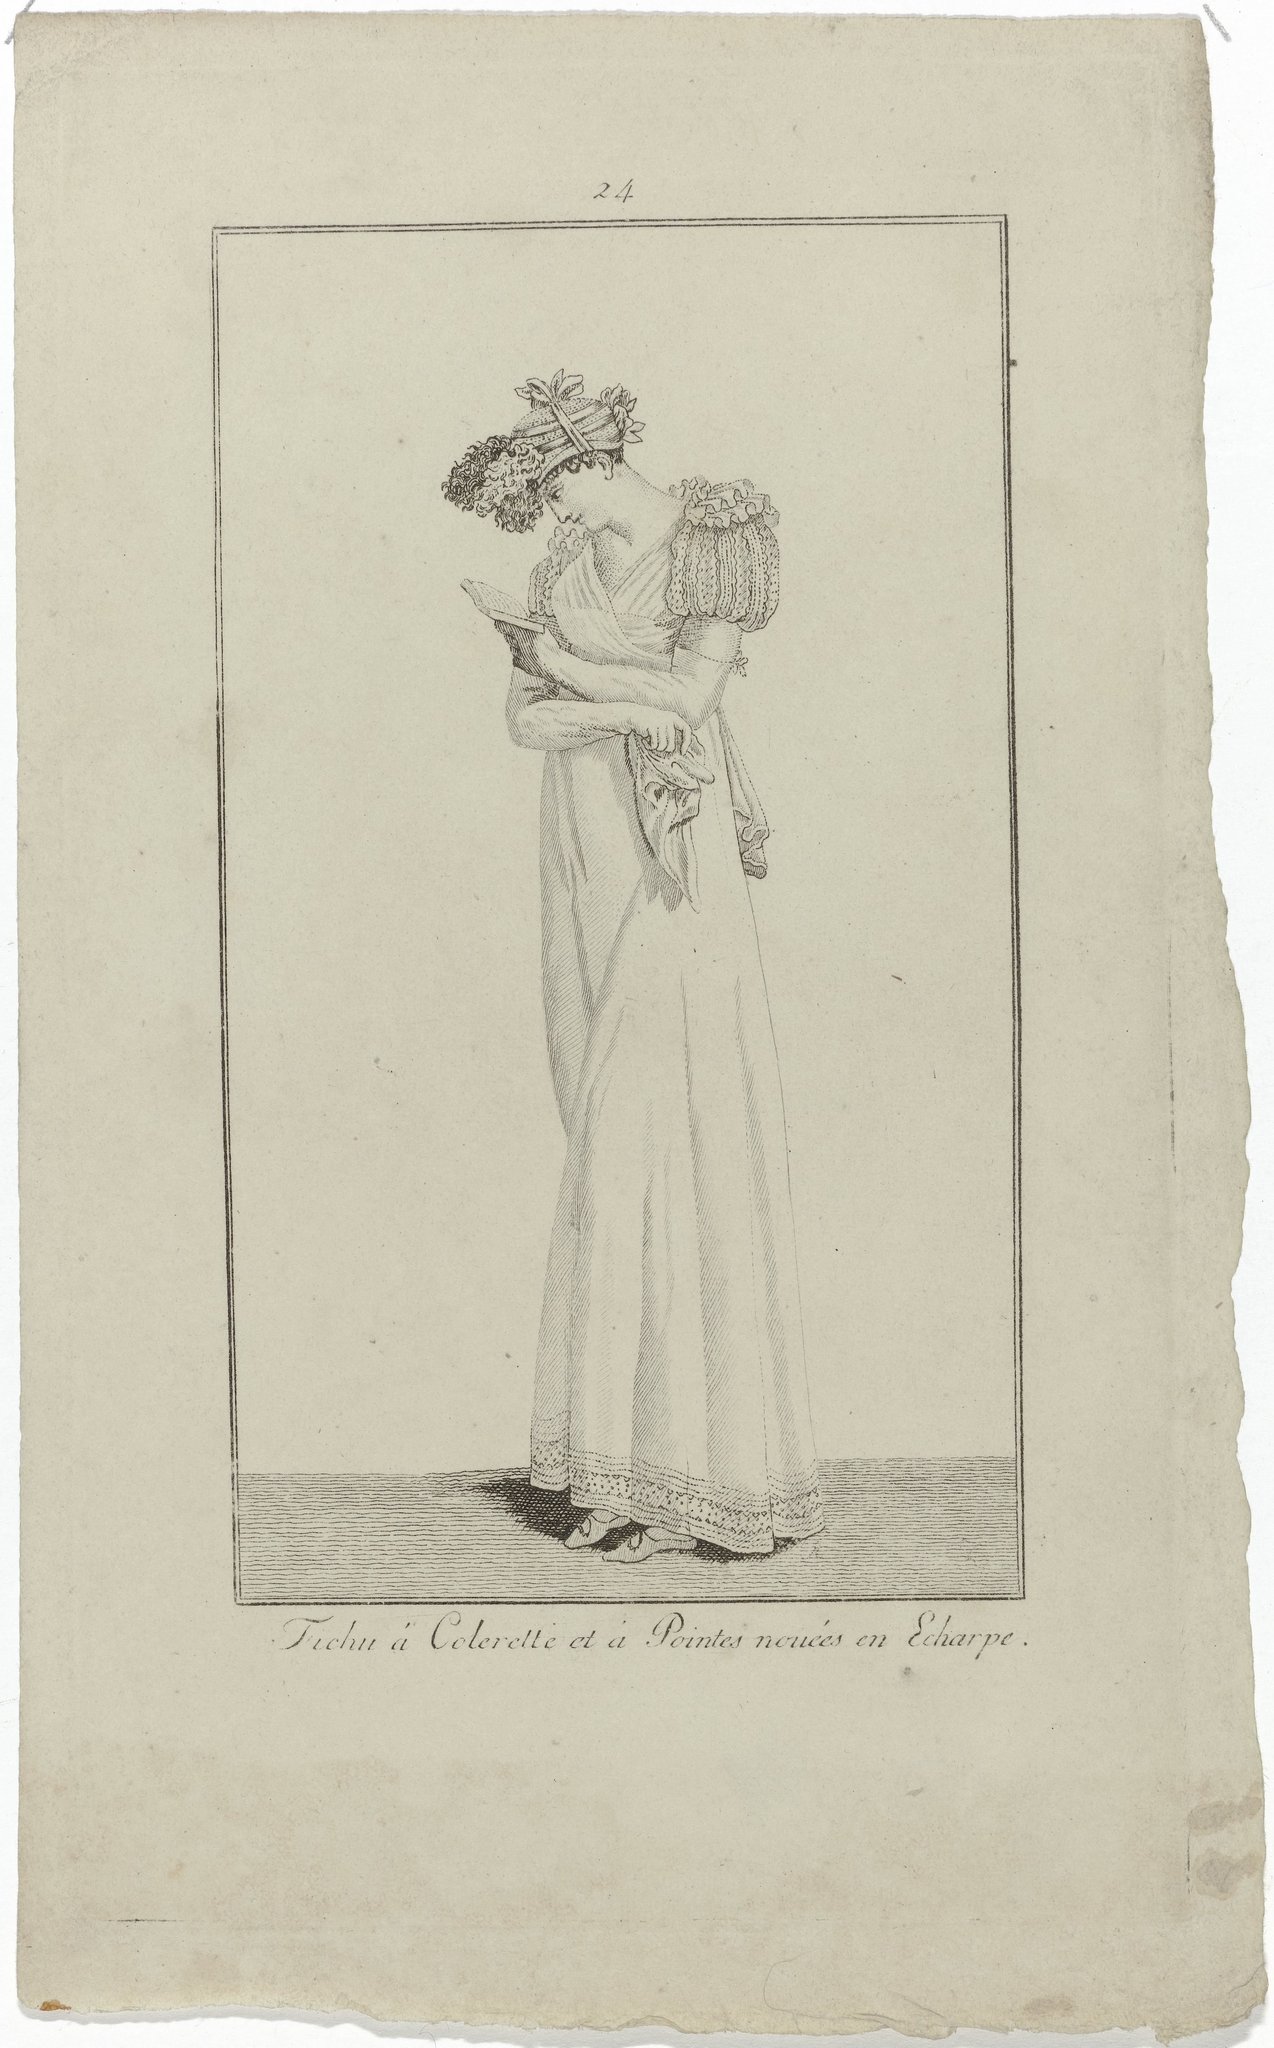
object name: fashion print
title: Elegantia, of tijdschrift van mode, luxe en smaak voor dames, Oktober 1807, No. 24 : Fichu á Colerett (...)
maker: Anonymous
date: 1807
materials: paper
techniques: engraving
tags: gloves, mittens (long gloves) (+ women's clothes), reading, head-gear (straw hat) (+ women's clothes), fashion plates, shoes, sandals (+ women's clothes), neck-gear ~ clothing (with name) (+ women's clothes), dress, gown (+ women's clothes), book - mm - book open, piece of clothing covering the breast or décolleté (fichu) (+ women's clothes)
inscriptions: caption: ‘Fichu à Colerette et à Pointes nouées en Echarpe.’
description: Volgens de beschrijving in het tijdschrift (p. 328): Japon van witte mousseline 'la manches bouffantes'(pofmouwen). Fichu met 'colerette' met van achter toegebonden punten. Strohoed met 'folettes'. Prent uit het modetijdschrift Elegantia, of tijdschrift van mode, luxe en smaak voor dames 1807-1814 (onderbroken door de periode 1811-1813).